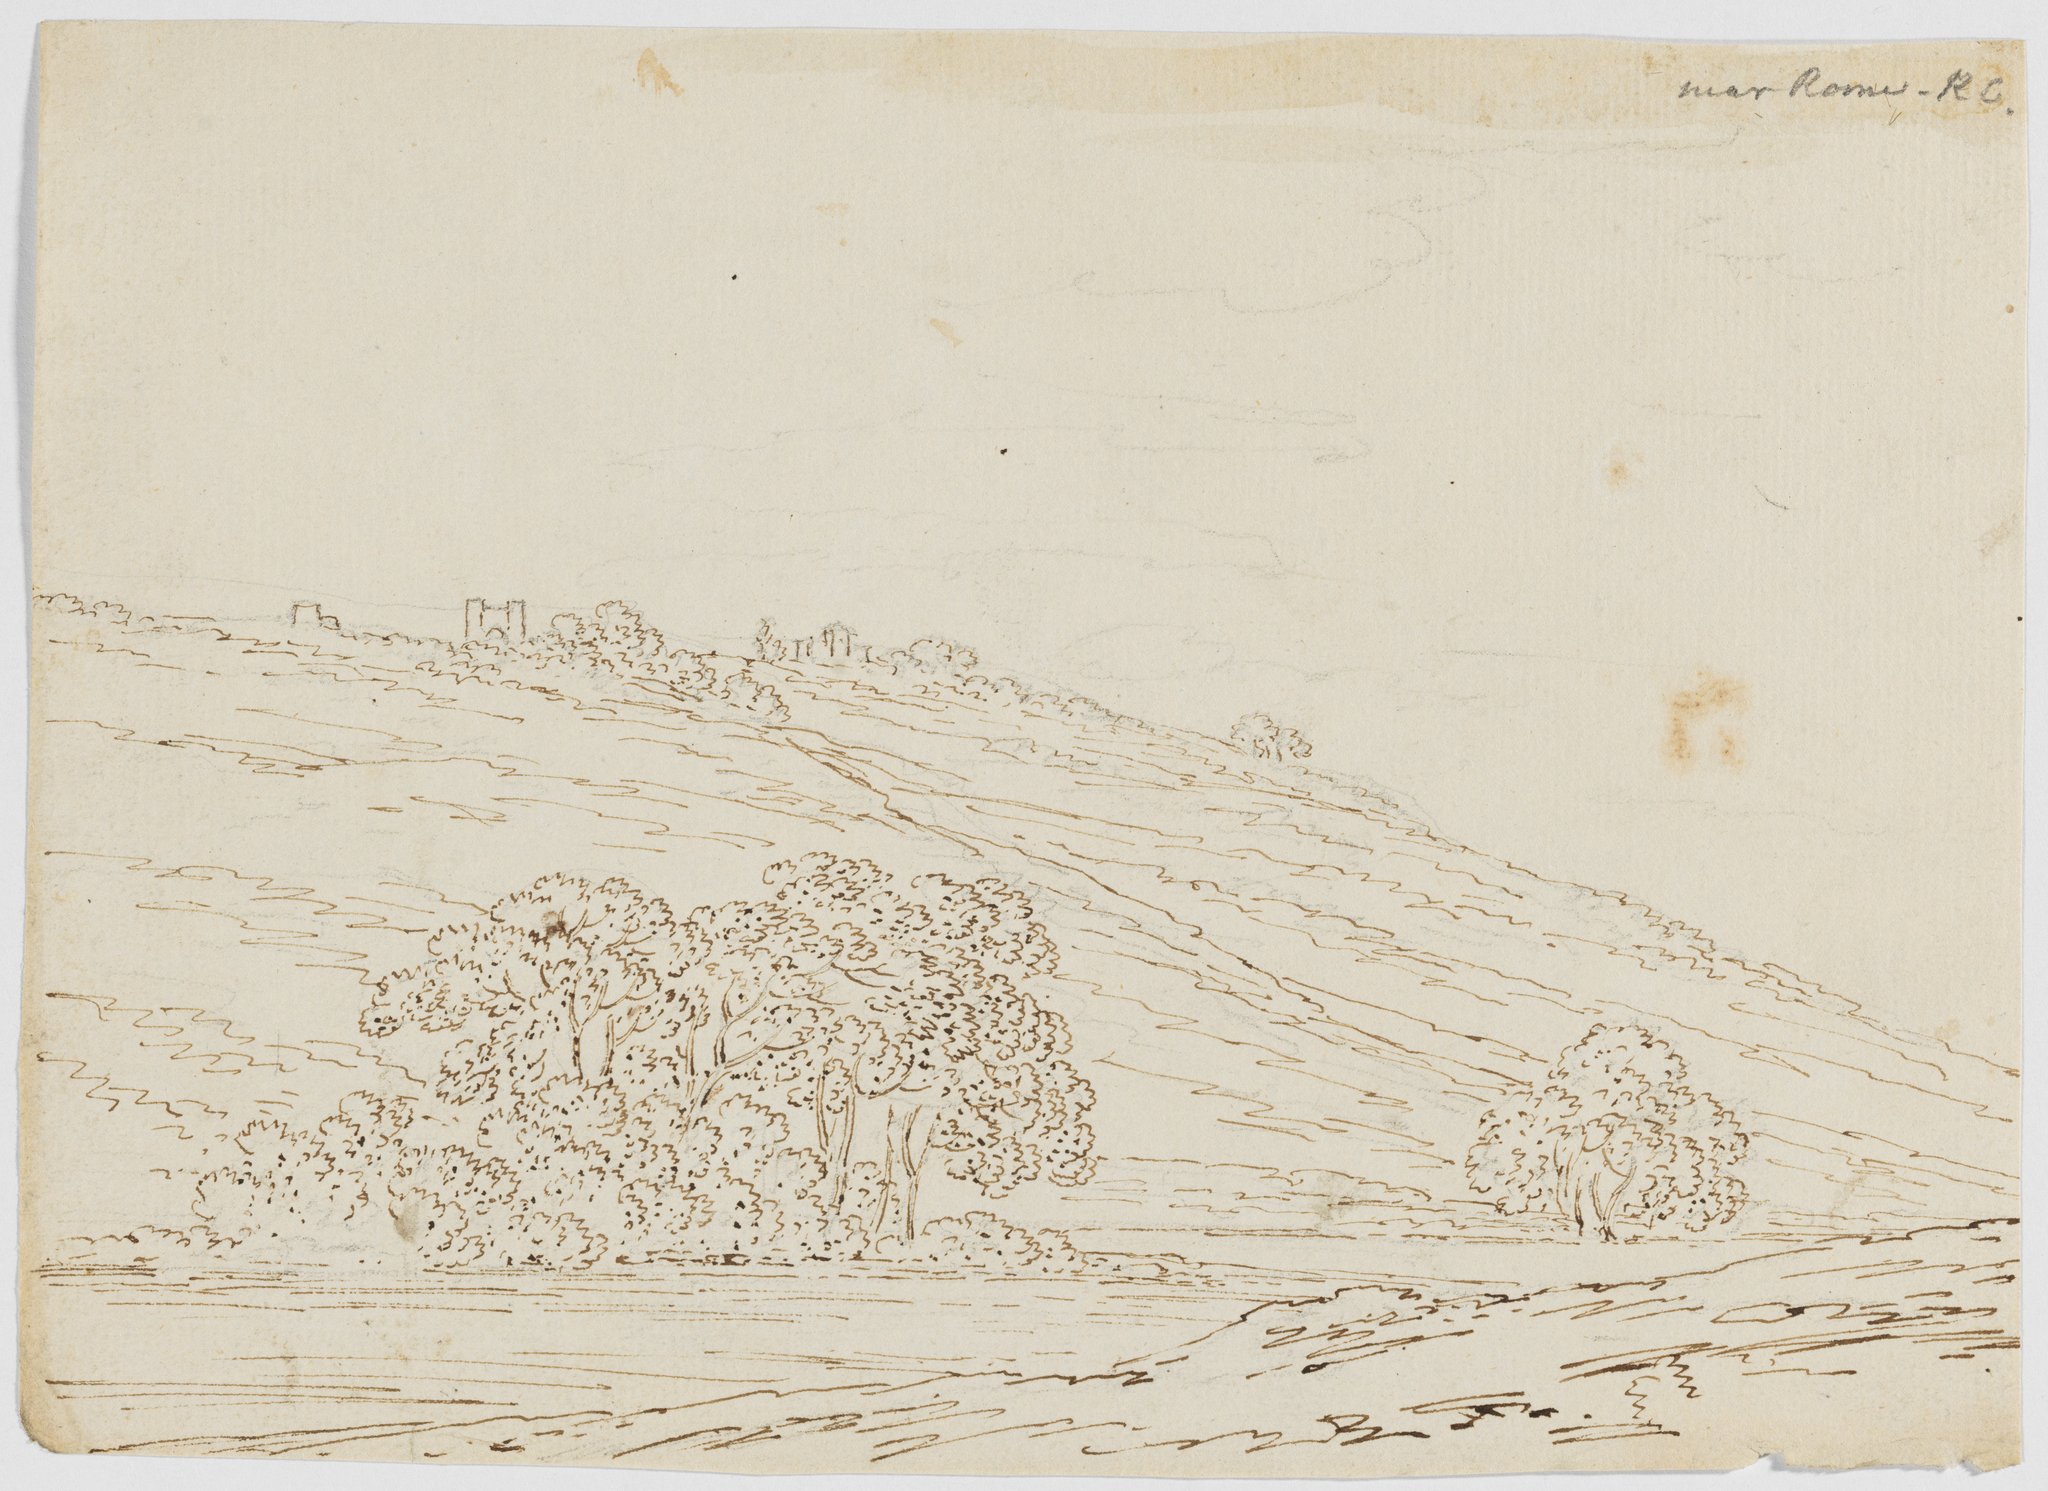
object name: drawing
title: Near Rome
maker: richard cooper ii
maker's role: artist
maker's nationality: british, scottish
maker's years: 1740-1822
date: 1774-1775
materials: graphite, ink, iron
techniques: pen